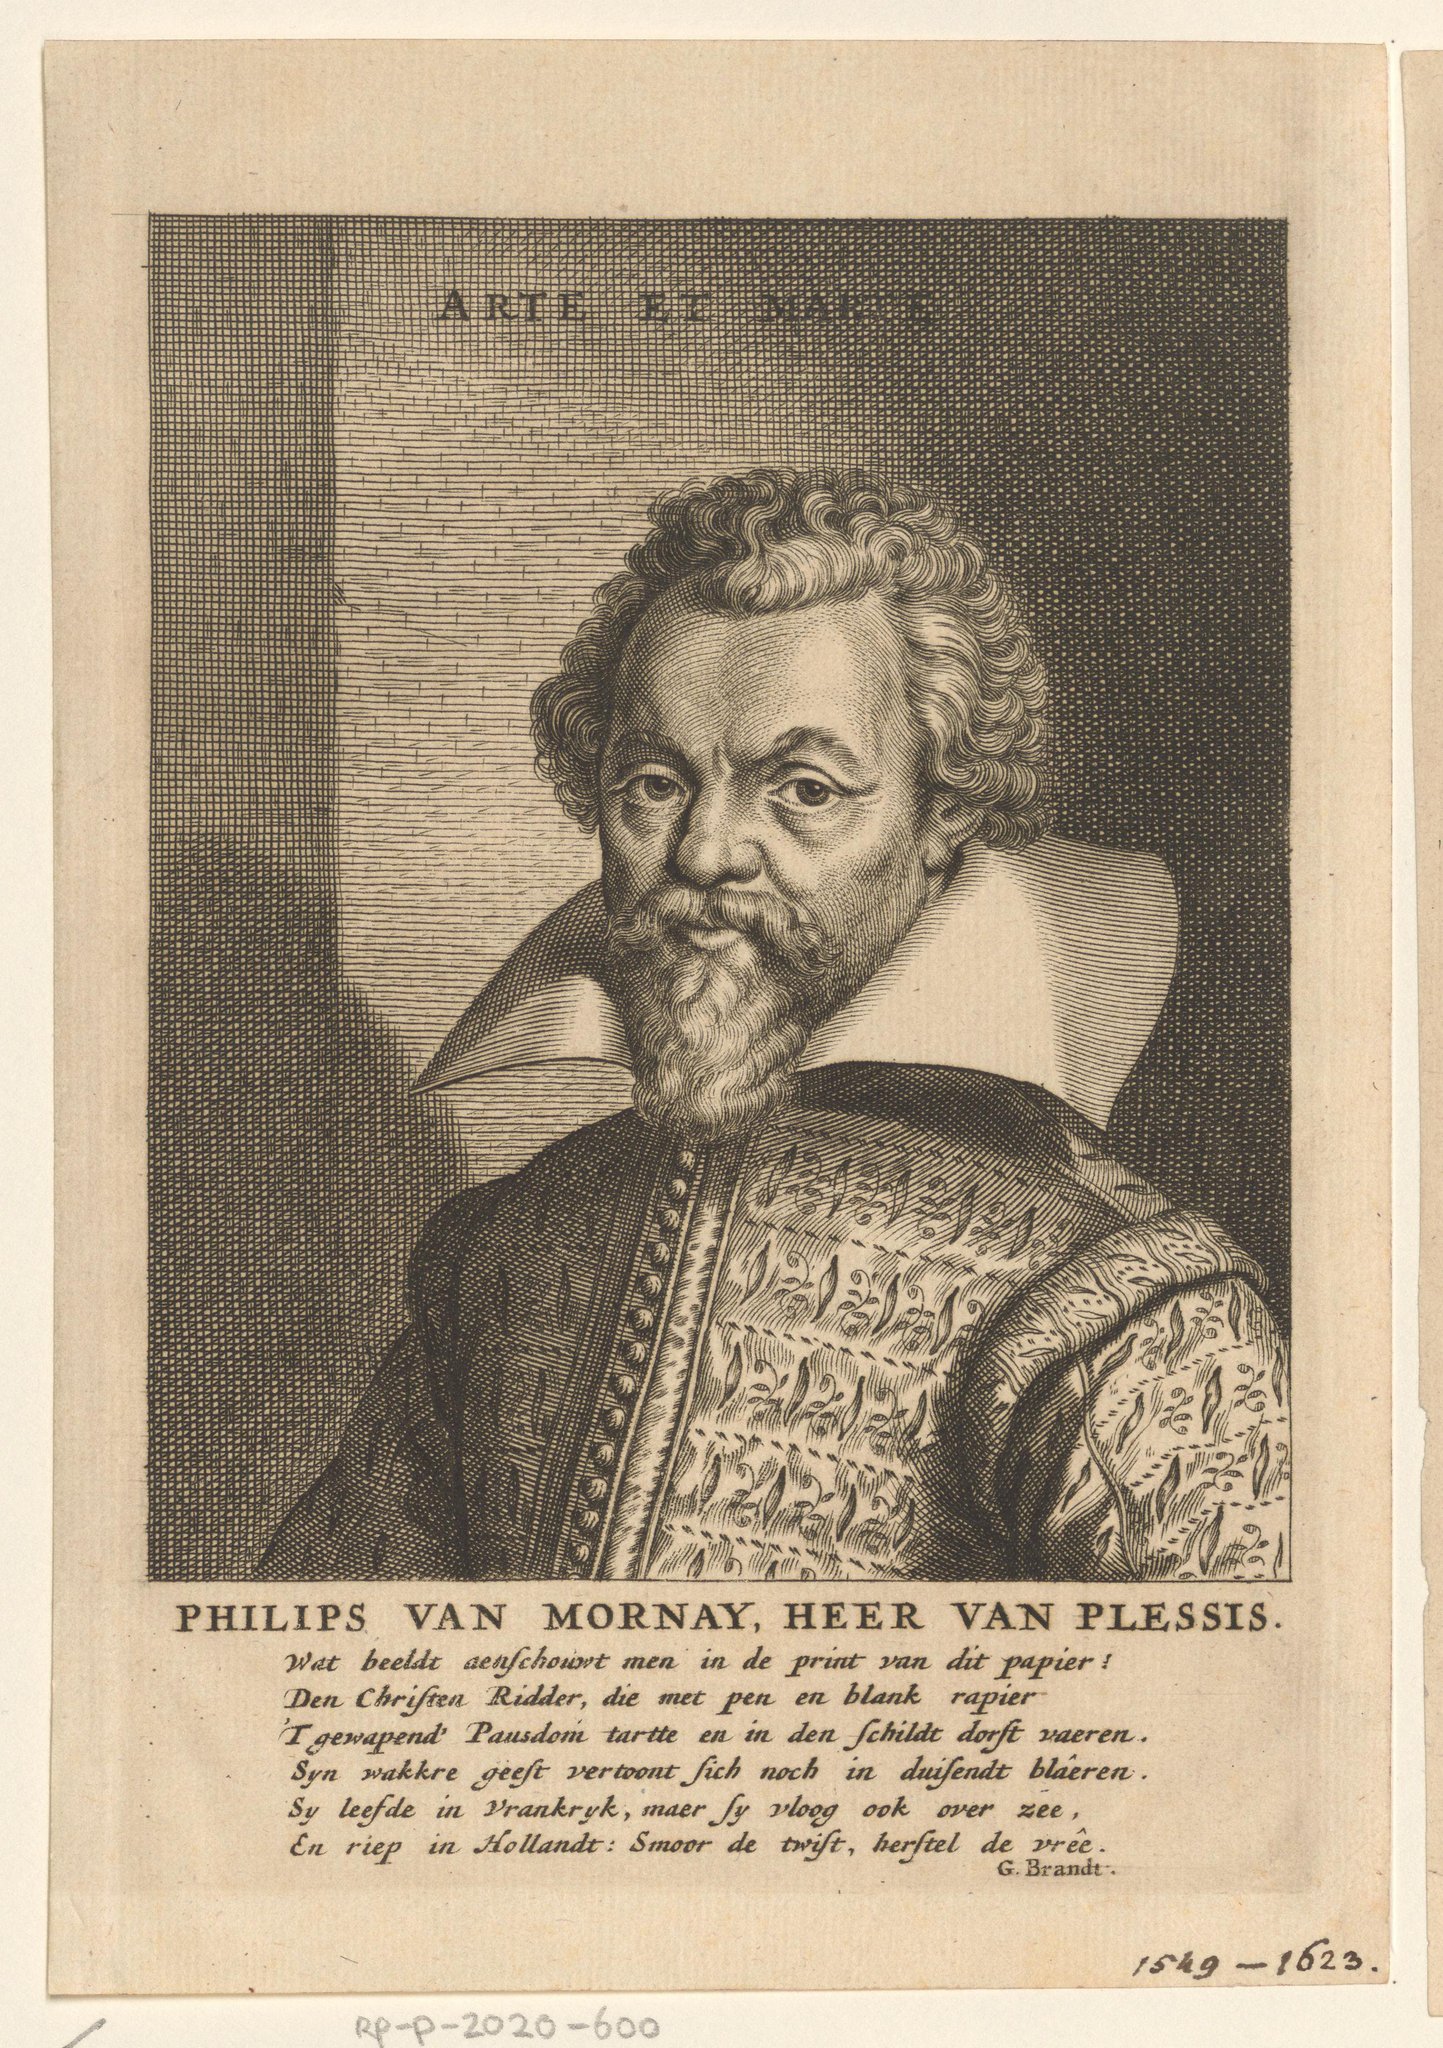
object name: print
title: Portret van Philippe du Plessis-Mornay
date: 1674-1677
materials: paper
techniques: engraving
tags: theologian, historical persons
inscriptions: collector's mark: Lugt 2228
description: FMP noemt Jan Lamsvelt als mogelijke prentmaker, maar dit is vanwege de datering niet mogelijk. Prent waarschijnlijk uit: Brandt, Geeraert (I). Historie der Reformatie (...). Amsterdam: Jan Rieuwertsz., Hendrik en Dirk Boom, 1674, dl. 2, tussen p. 520 en 521. Of uit een latere editie van het werk, uitgegeven in 1677.